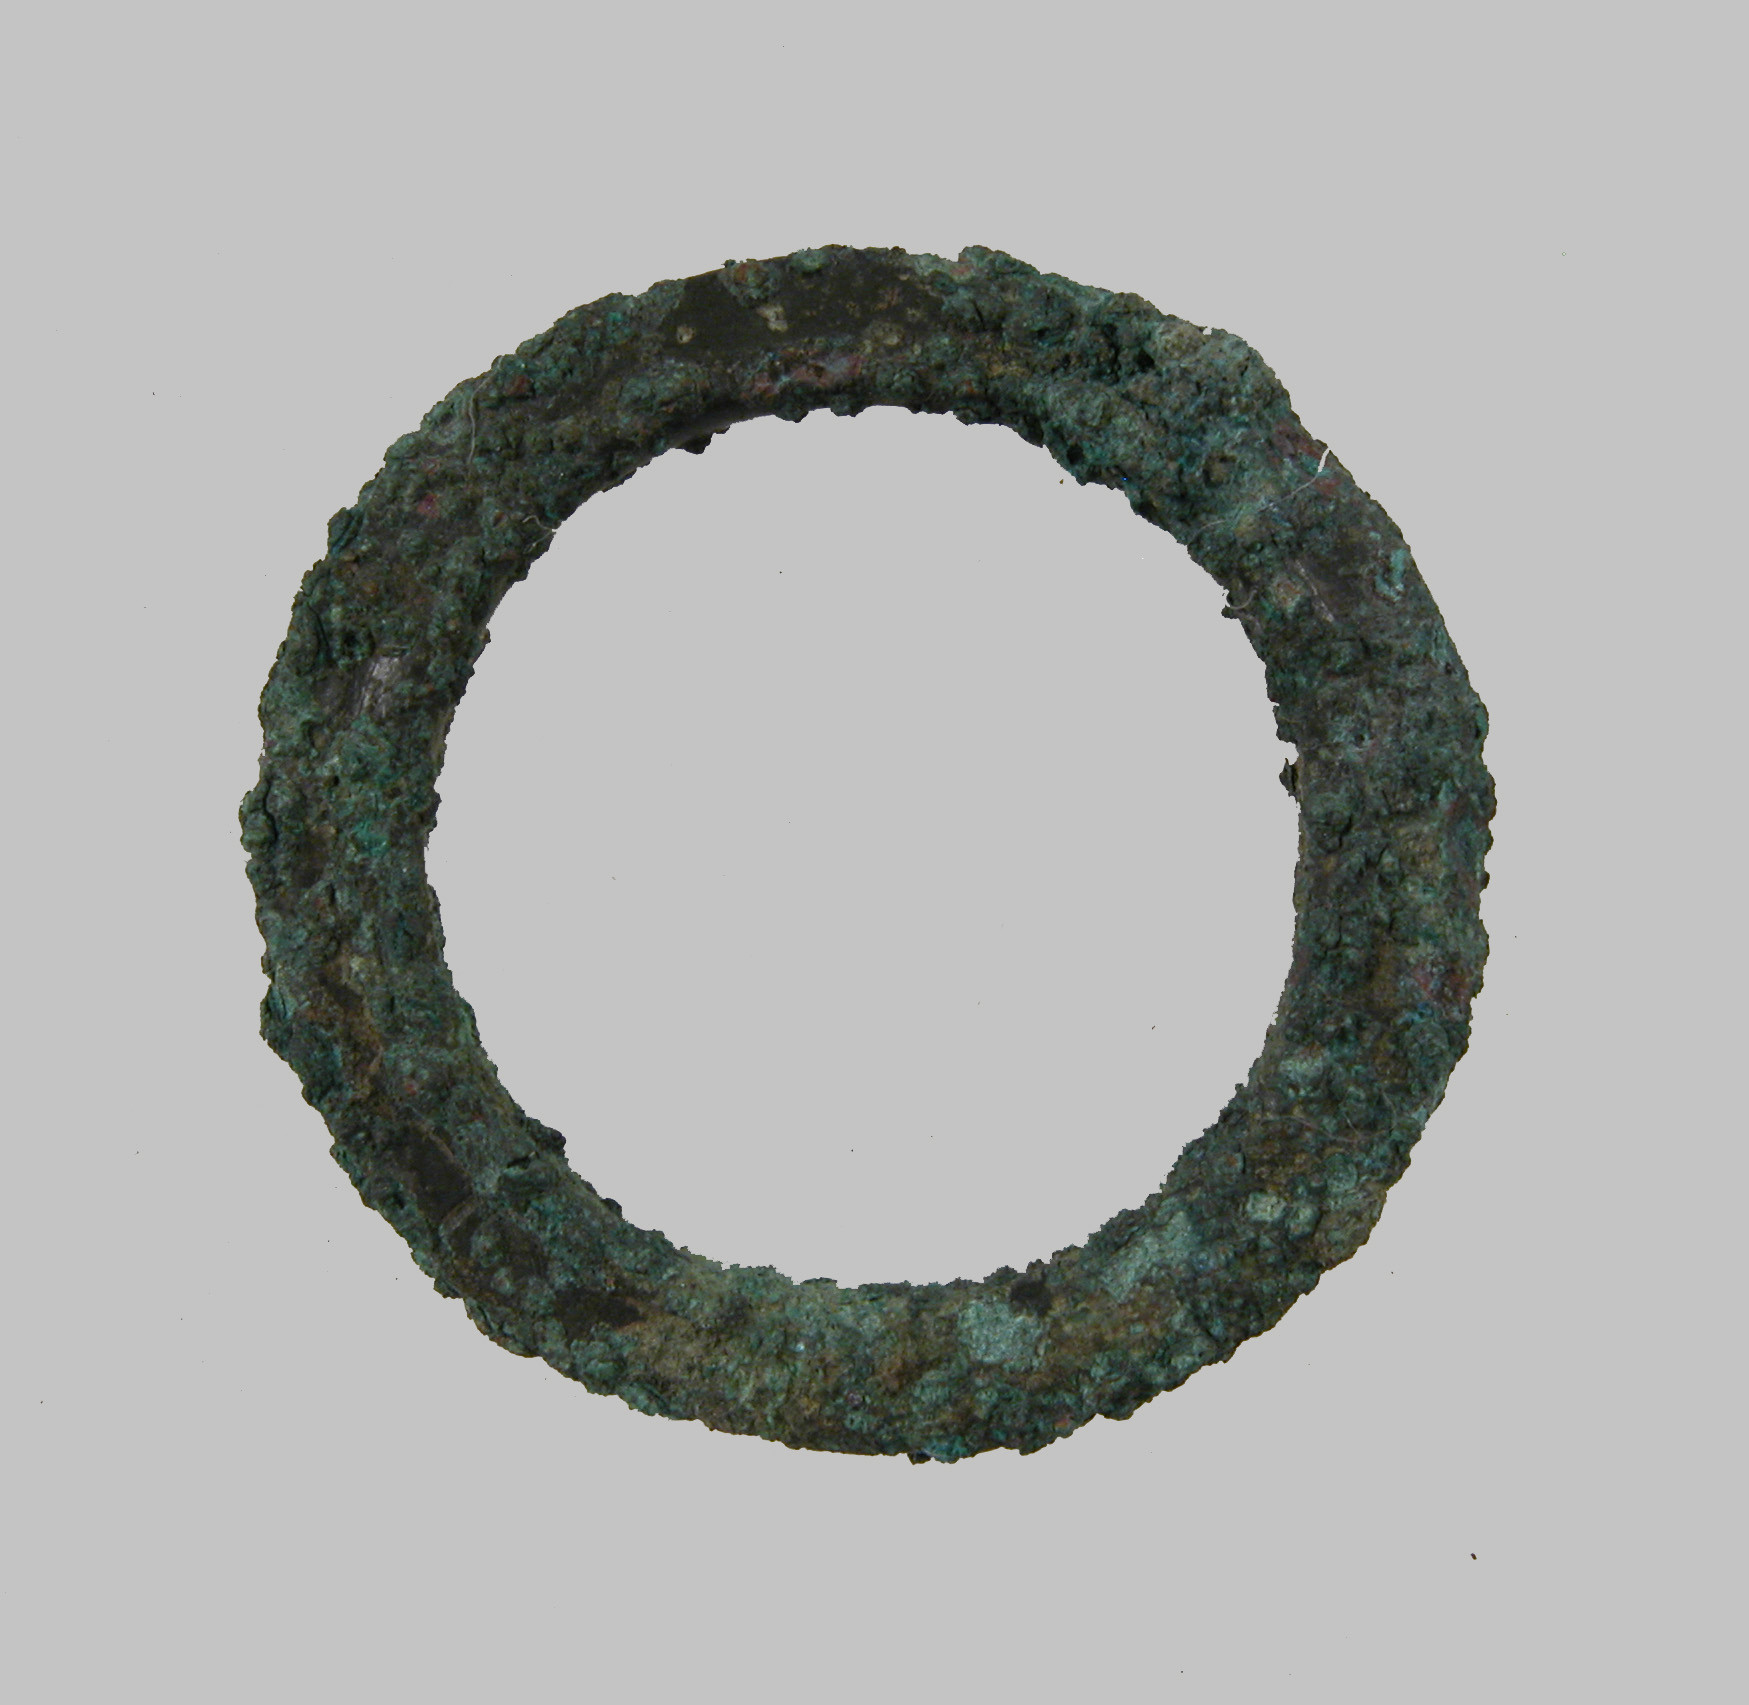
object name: ring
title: Plain Ring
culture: frankish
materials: copper alloy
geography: germany